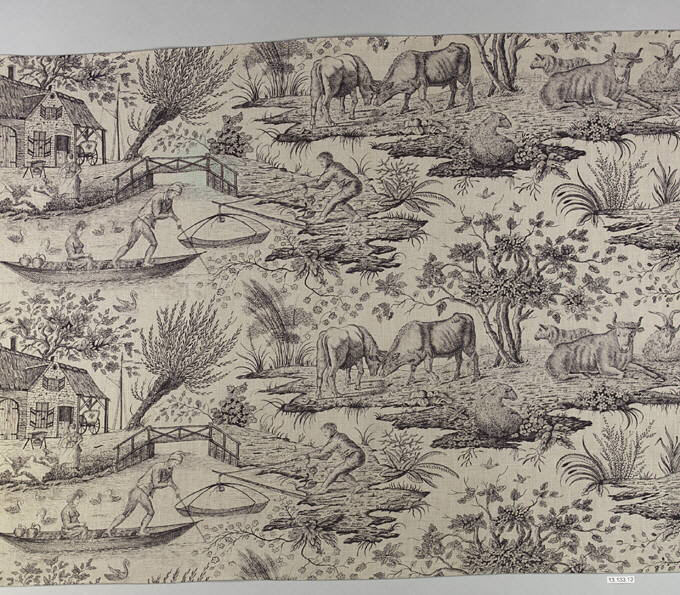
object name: furnishing textile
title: Pictorial print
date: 1801-1900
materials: cotton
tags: men,women,cows,trees,boats